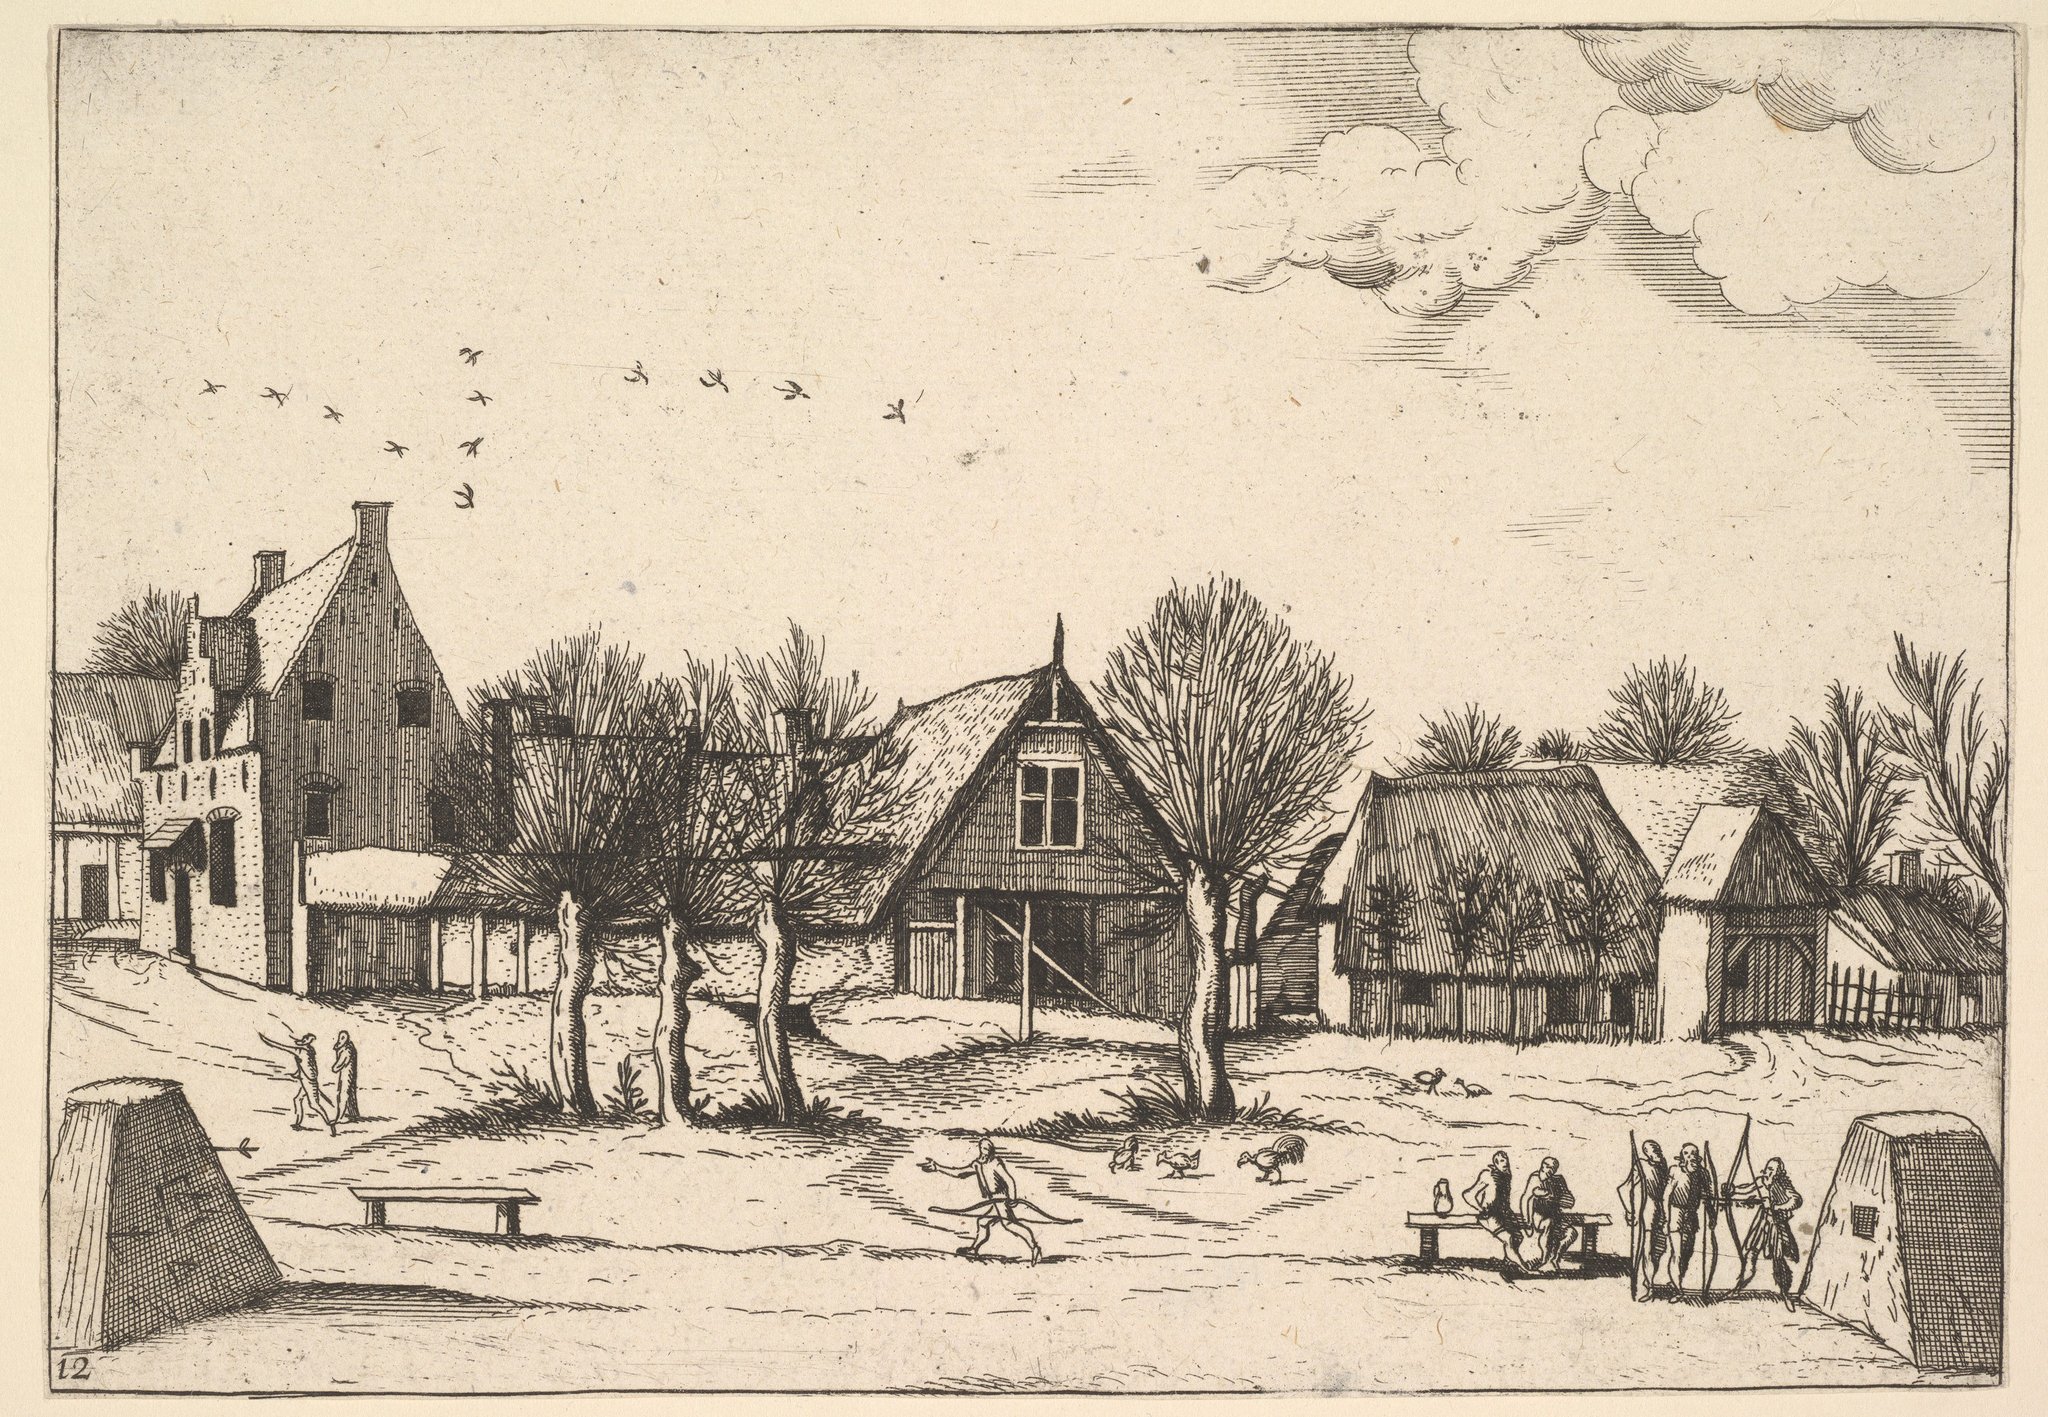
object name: print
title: Country Village, archers in the foreground from Multifariarum casularum ruriumque lineamenta curiose ad vivum expressa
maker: johannes van doetecum i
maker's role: artist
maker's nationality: netherlandish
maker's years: 1528-1605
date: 1559-1561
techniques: etching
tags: human figures,houses,villages